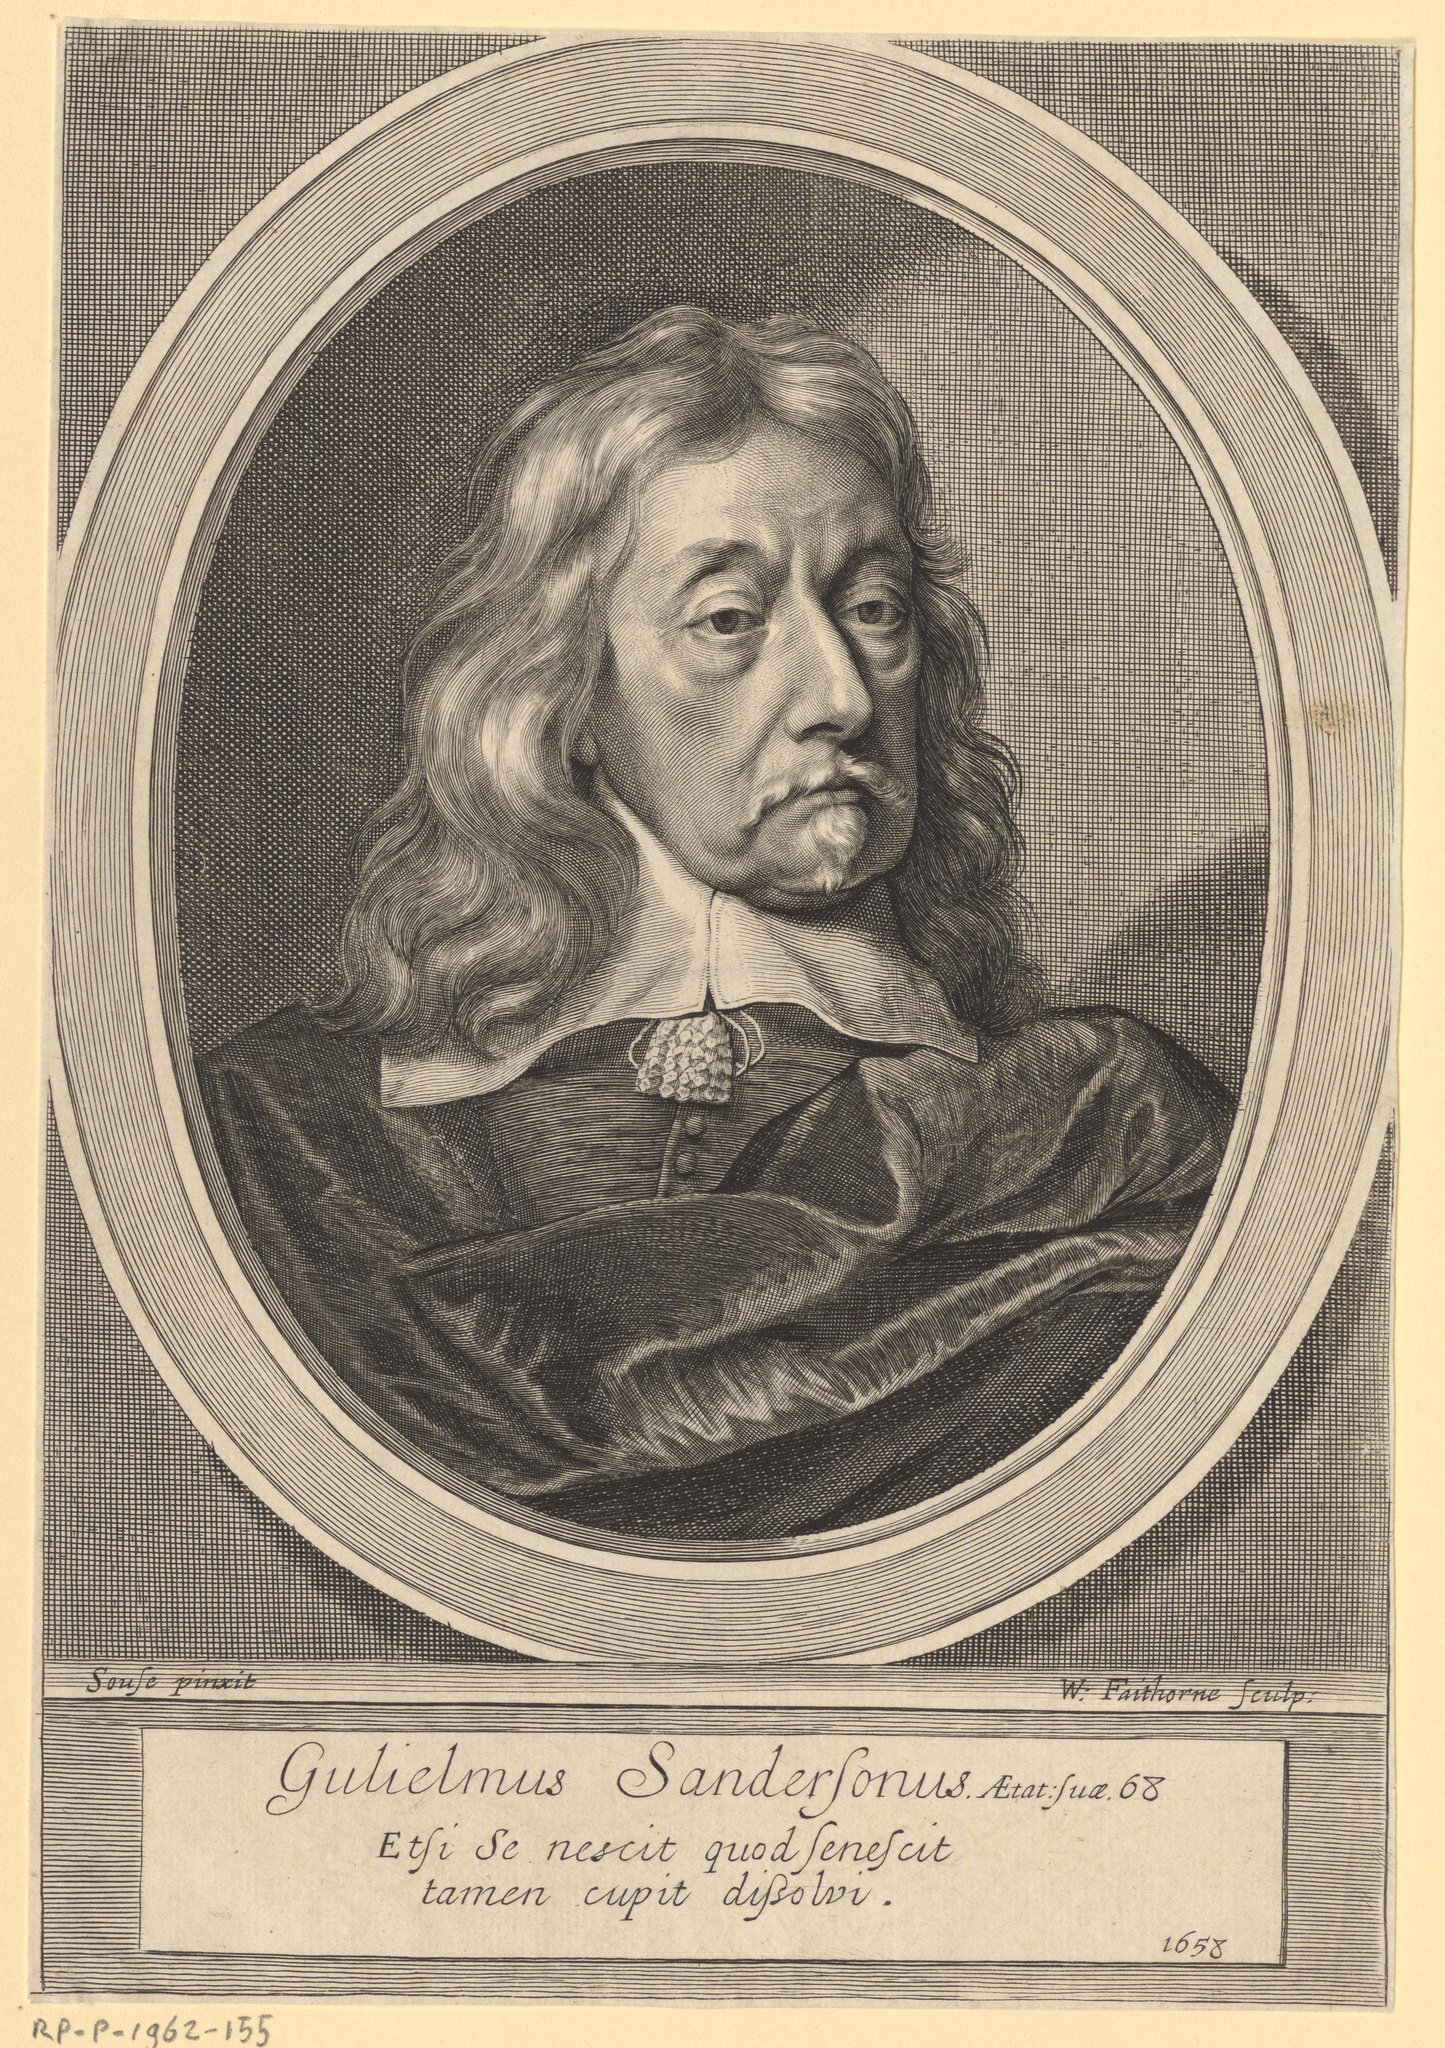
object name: print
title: Portret van William Sanderson op 68-jarige leeftijd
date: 1658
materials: paper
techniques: engraving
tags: william sanderson, history, scholar, philosopher, historical persons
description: Prent mogelijk uit: Sanderson, William. Graphice, the use of the pen and pensil. Londen: Robert Crofts, 1658.